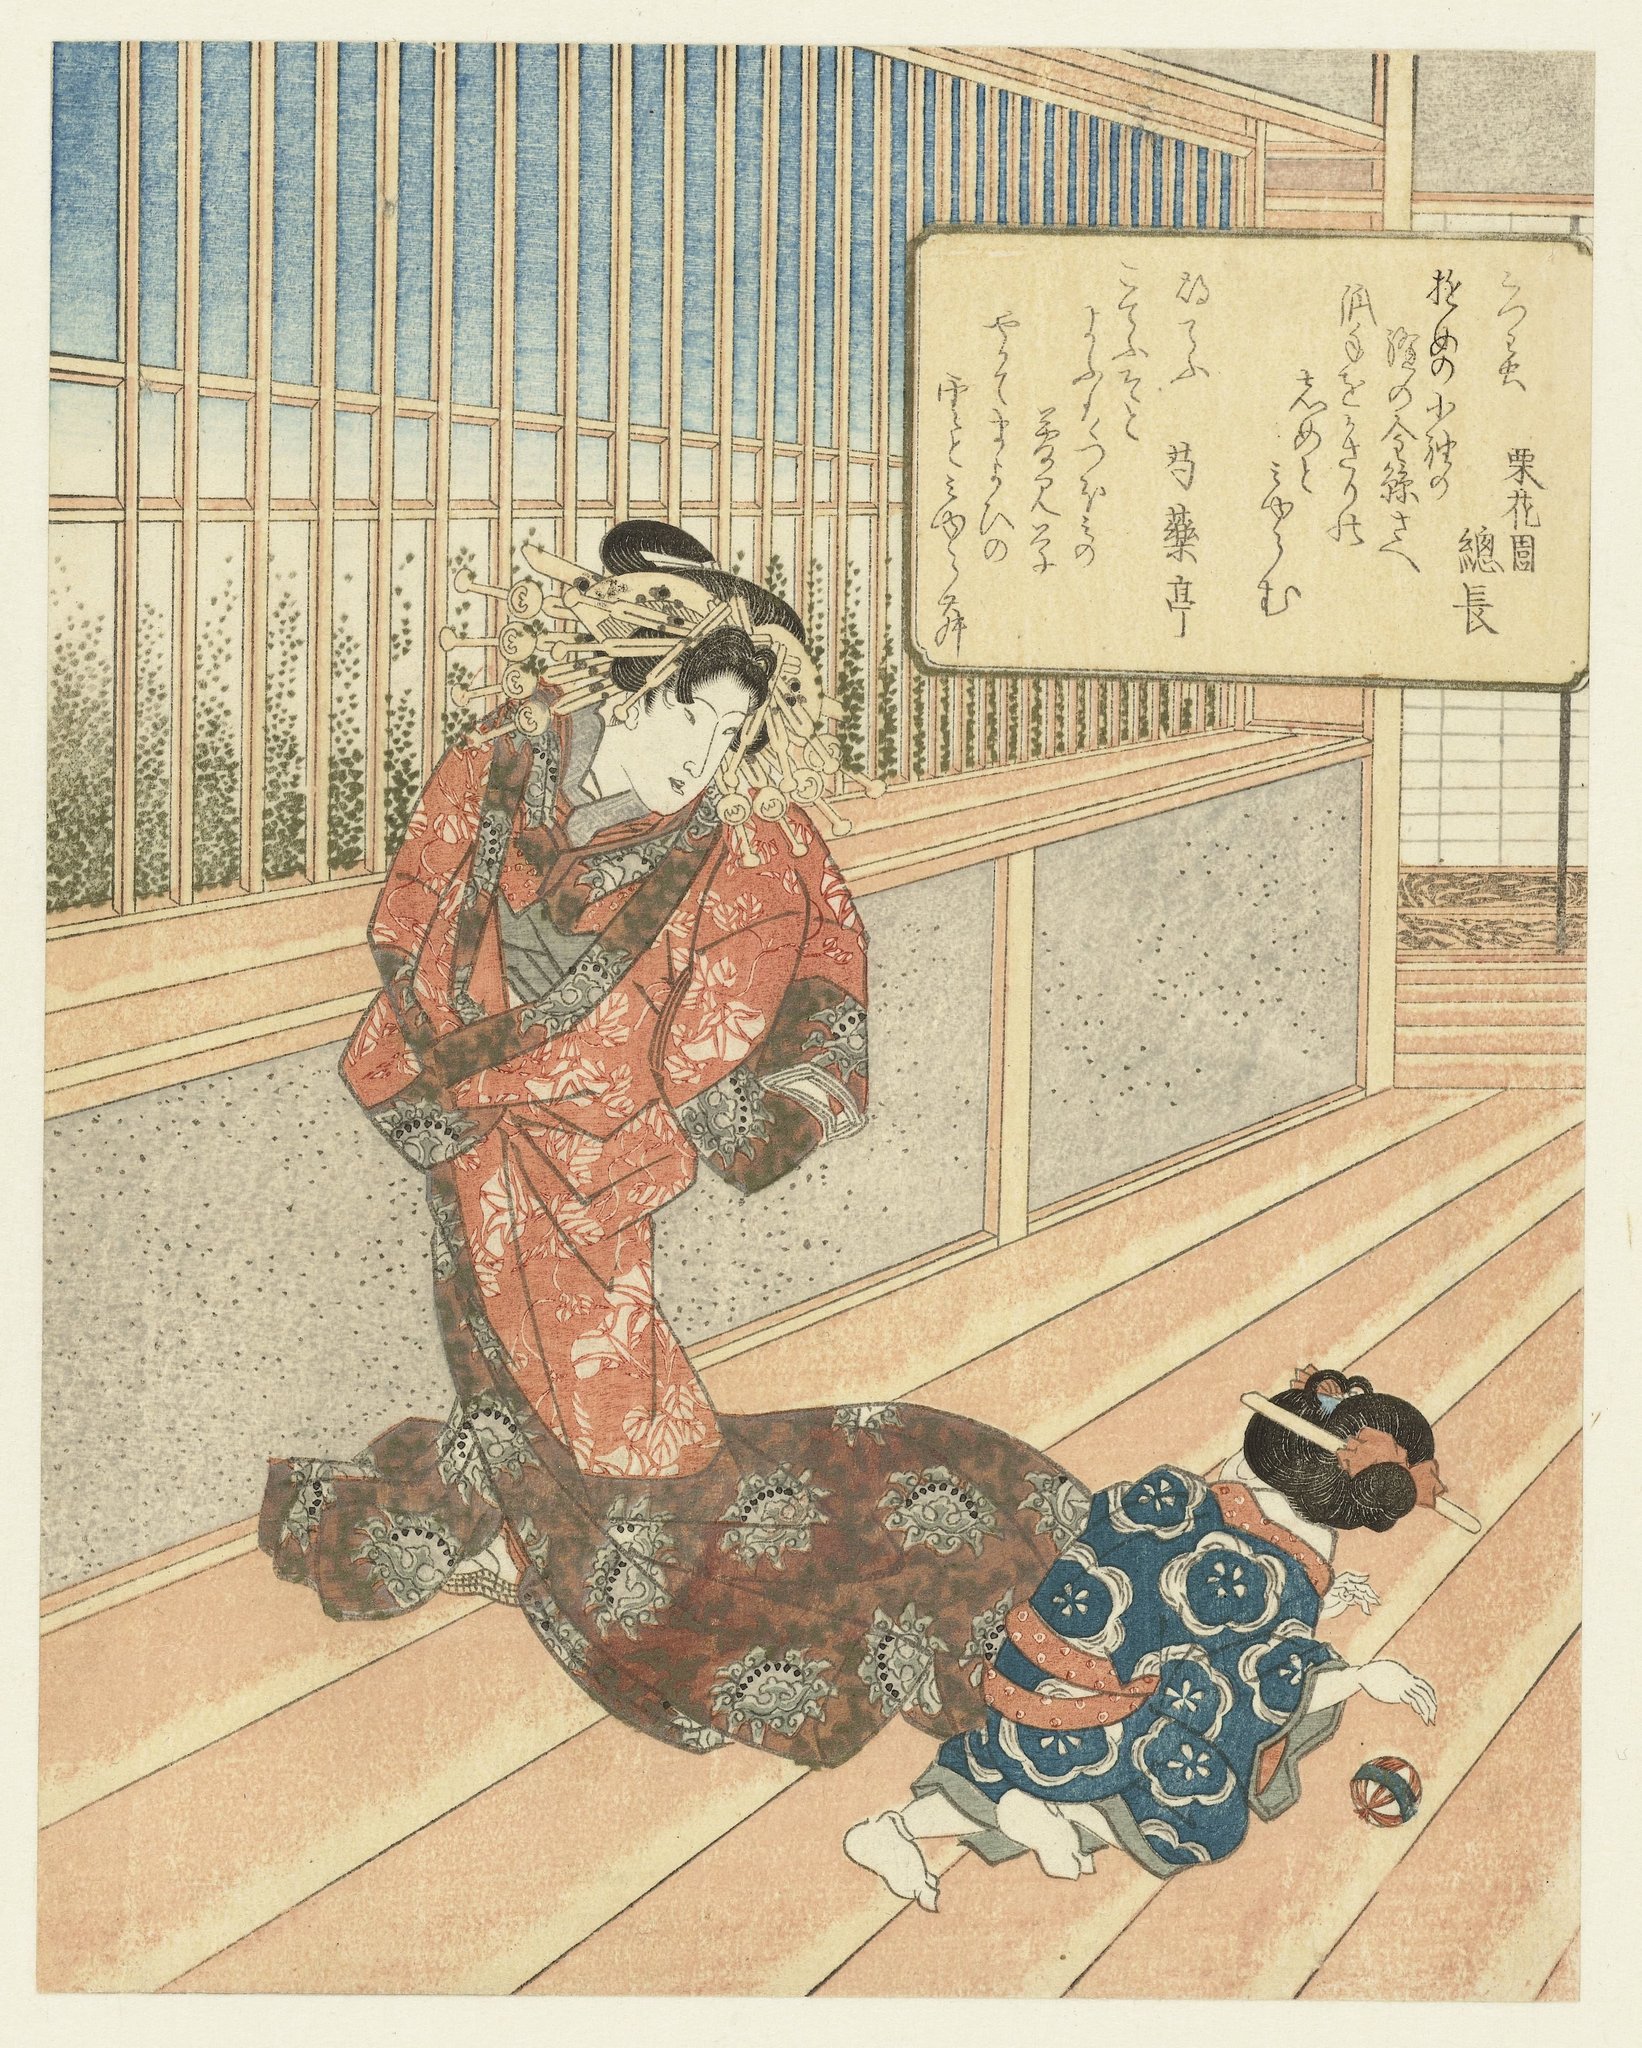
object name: print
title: A Courtesan Watches a Kamuro Playing with a Ball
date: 1825-1830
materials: paper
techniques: woodcut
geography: japan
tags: ball games (children's games)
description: Een surimono is een luxe uitgevoerde prent waarop beeld met één of meerdere gedichten gecombineerd is. Bij het drukken van een surimono werd vaak gebruik gemaakt van dikker papier, blinddruk en metaal pigmenten, zoals koper- en zilverpoeder. De prenten werden vaak in opdracht van dichters gemaakt en als exclusief geschenk aan vrienden en relaties gegeven.